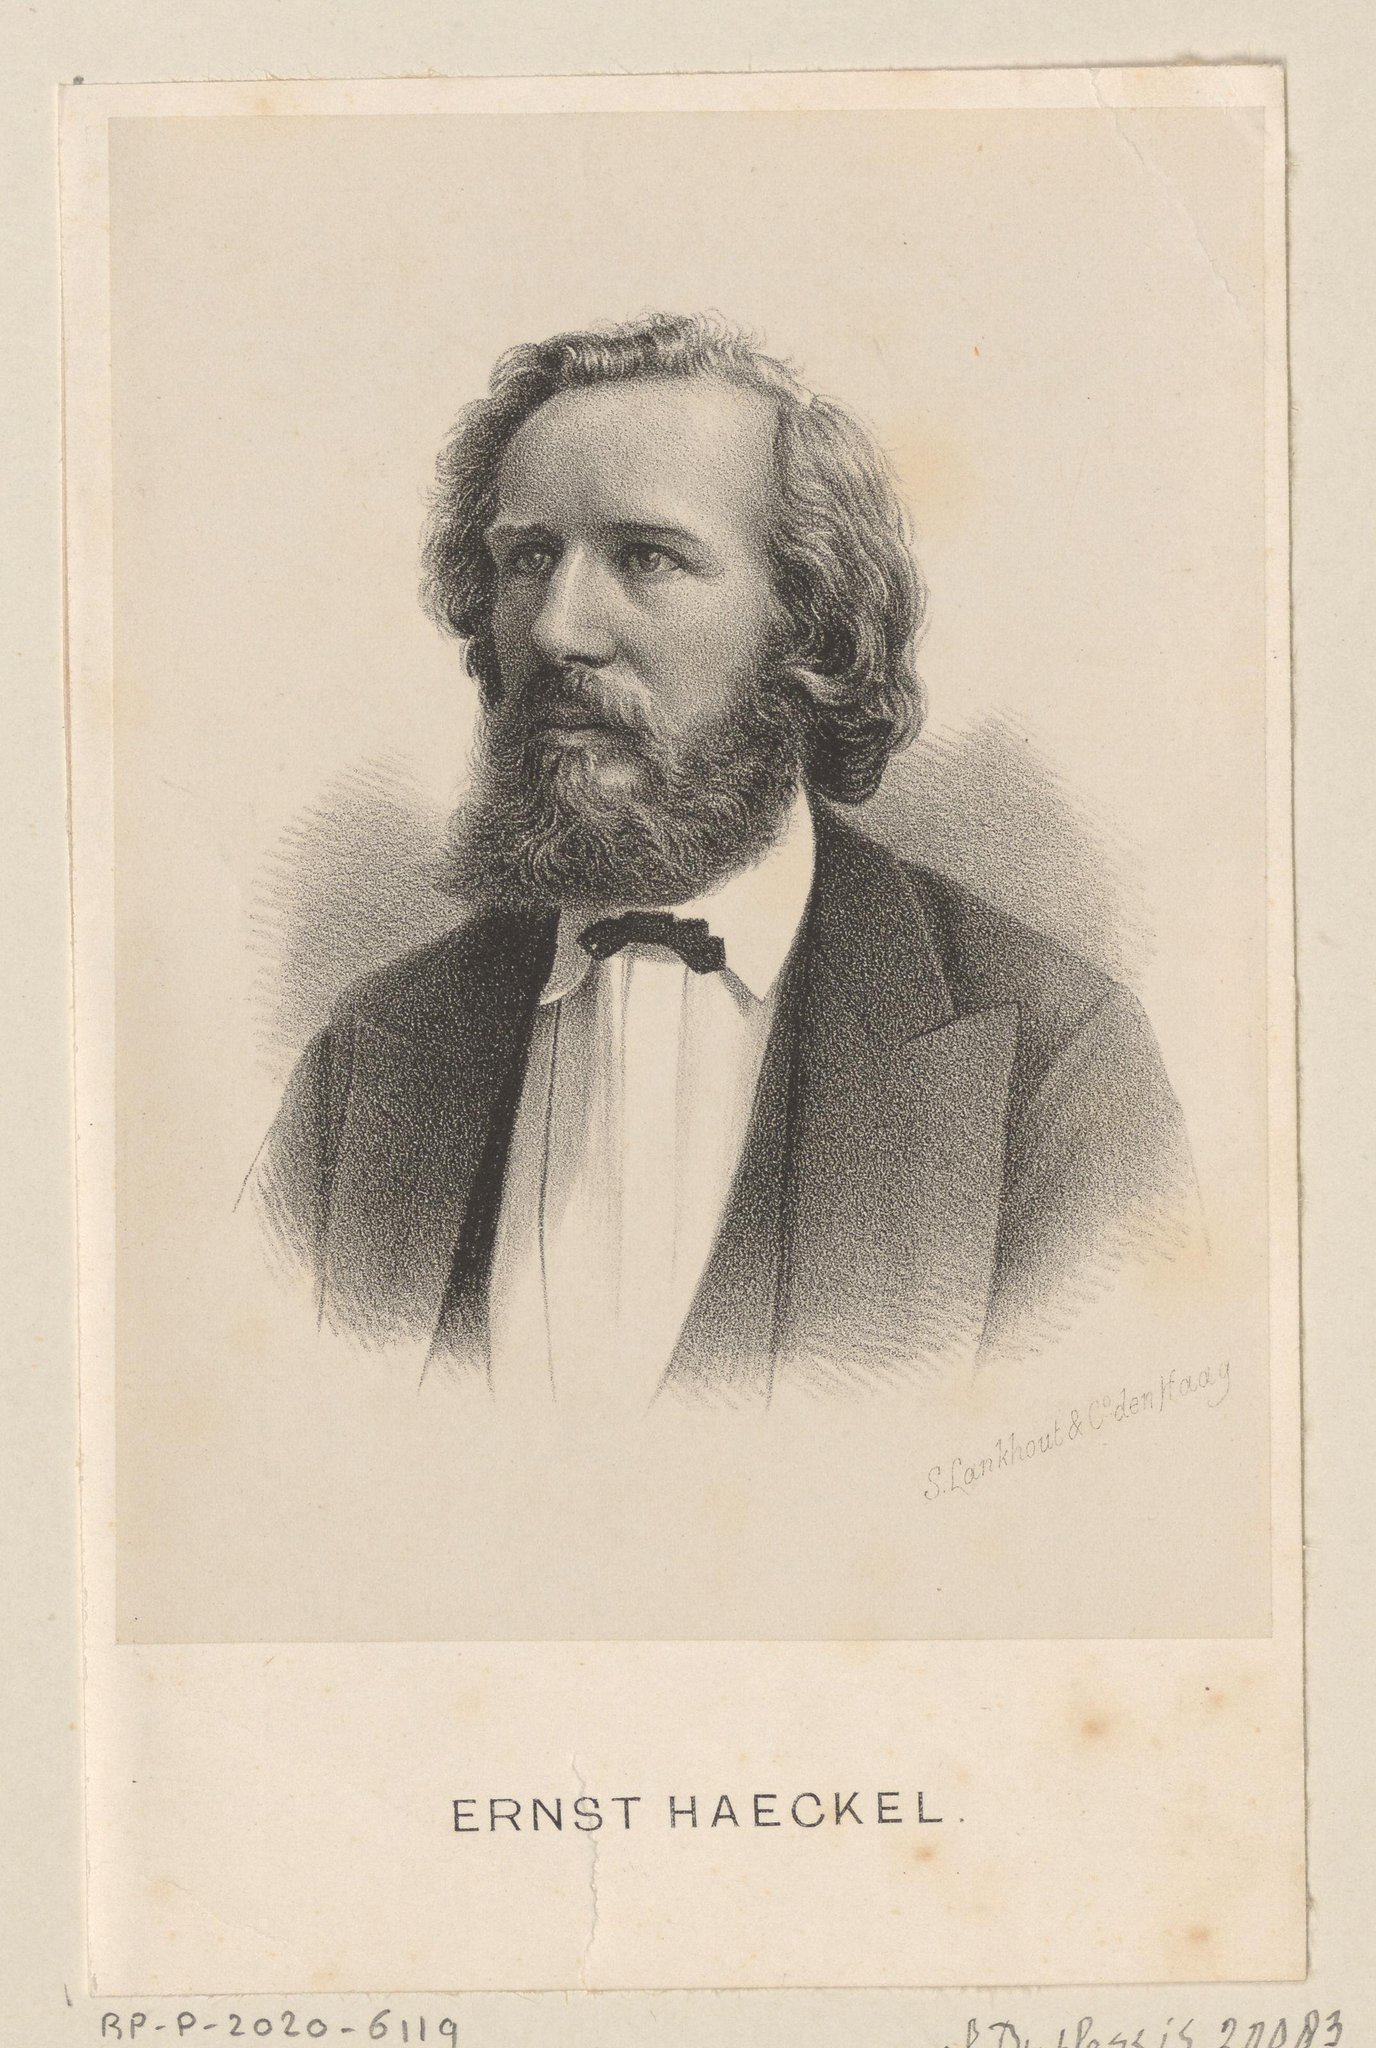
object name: print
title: Portret van Ernst Haeckel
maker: Anonymous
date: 1877-1903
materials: paper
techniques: lithograph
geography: the hague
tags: scholar, philosopher, historical persons